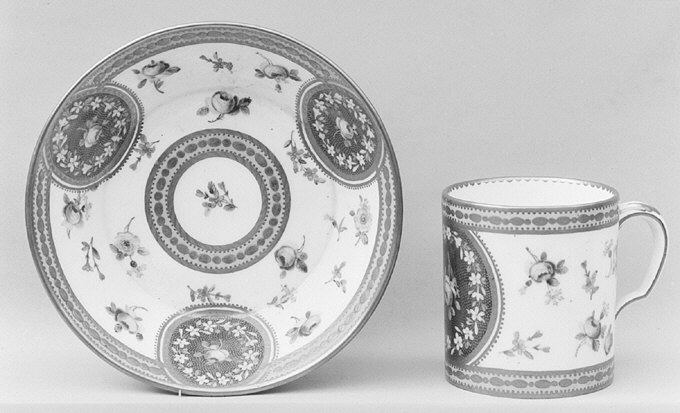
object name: cup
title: Cup (gobelet litron)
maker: sèvres manufactory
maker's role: manufactory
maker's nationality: french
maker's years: 1740-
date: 1782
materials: soft paste porcelain